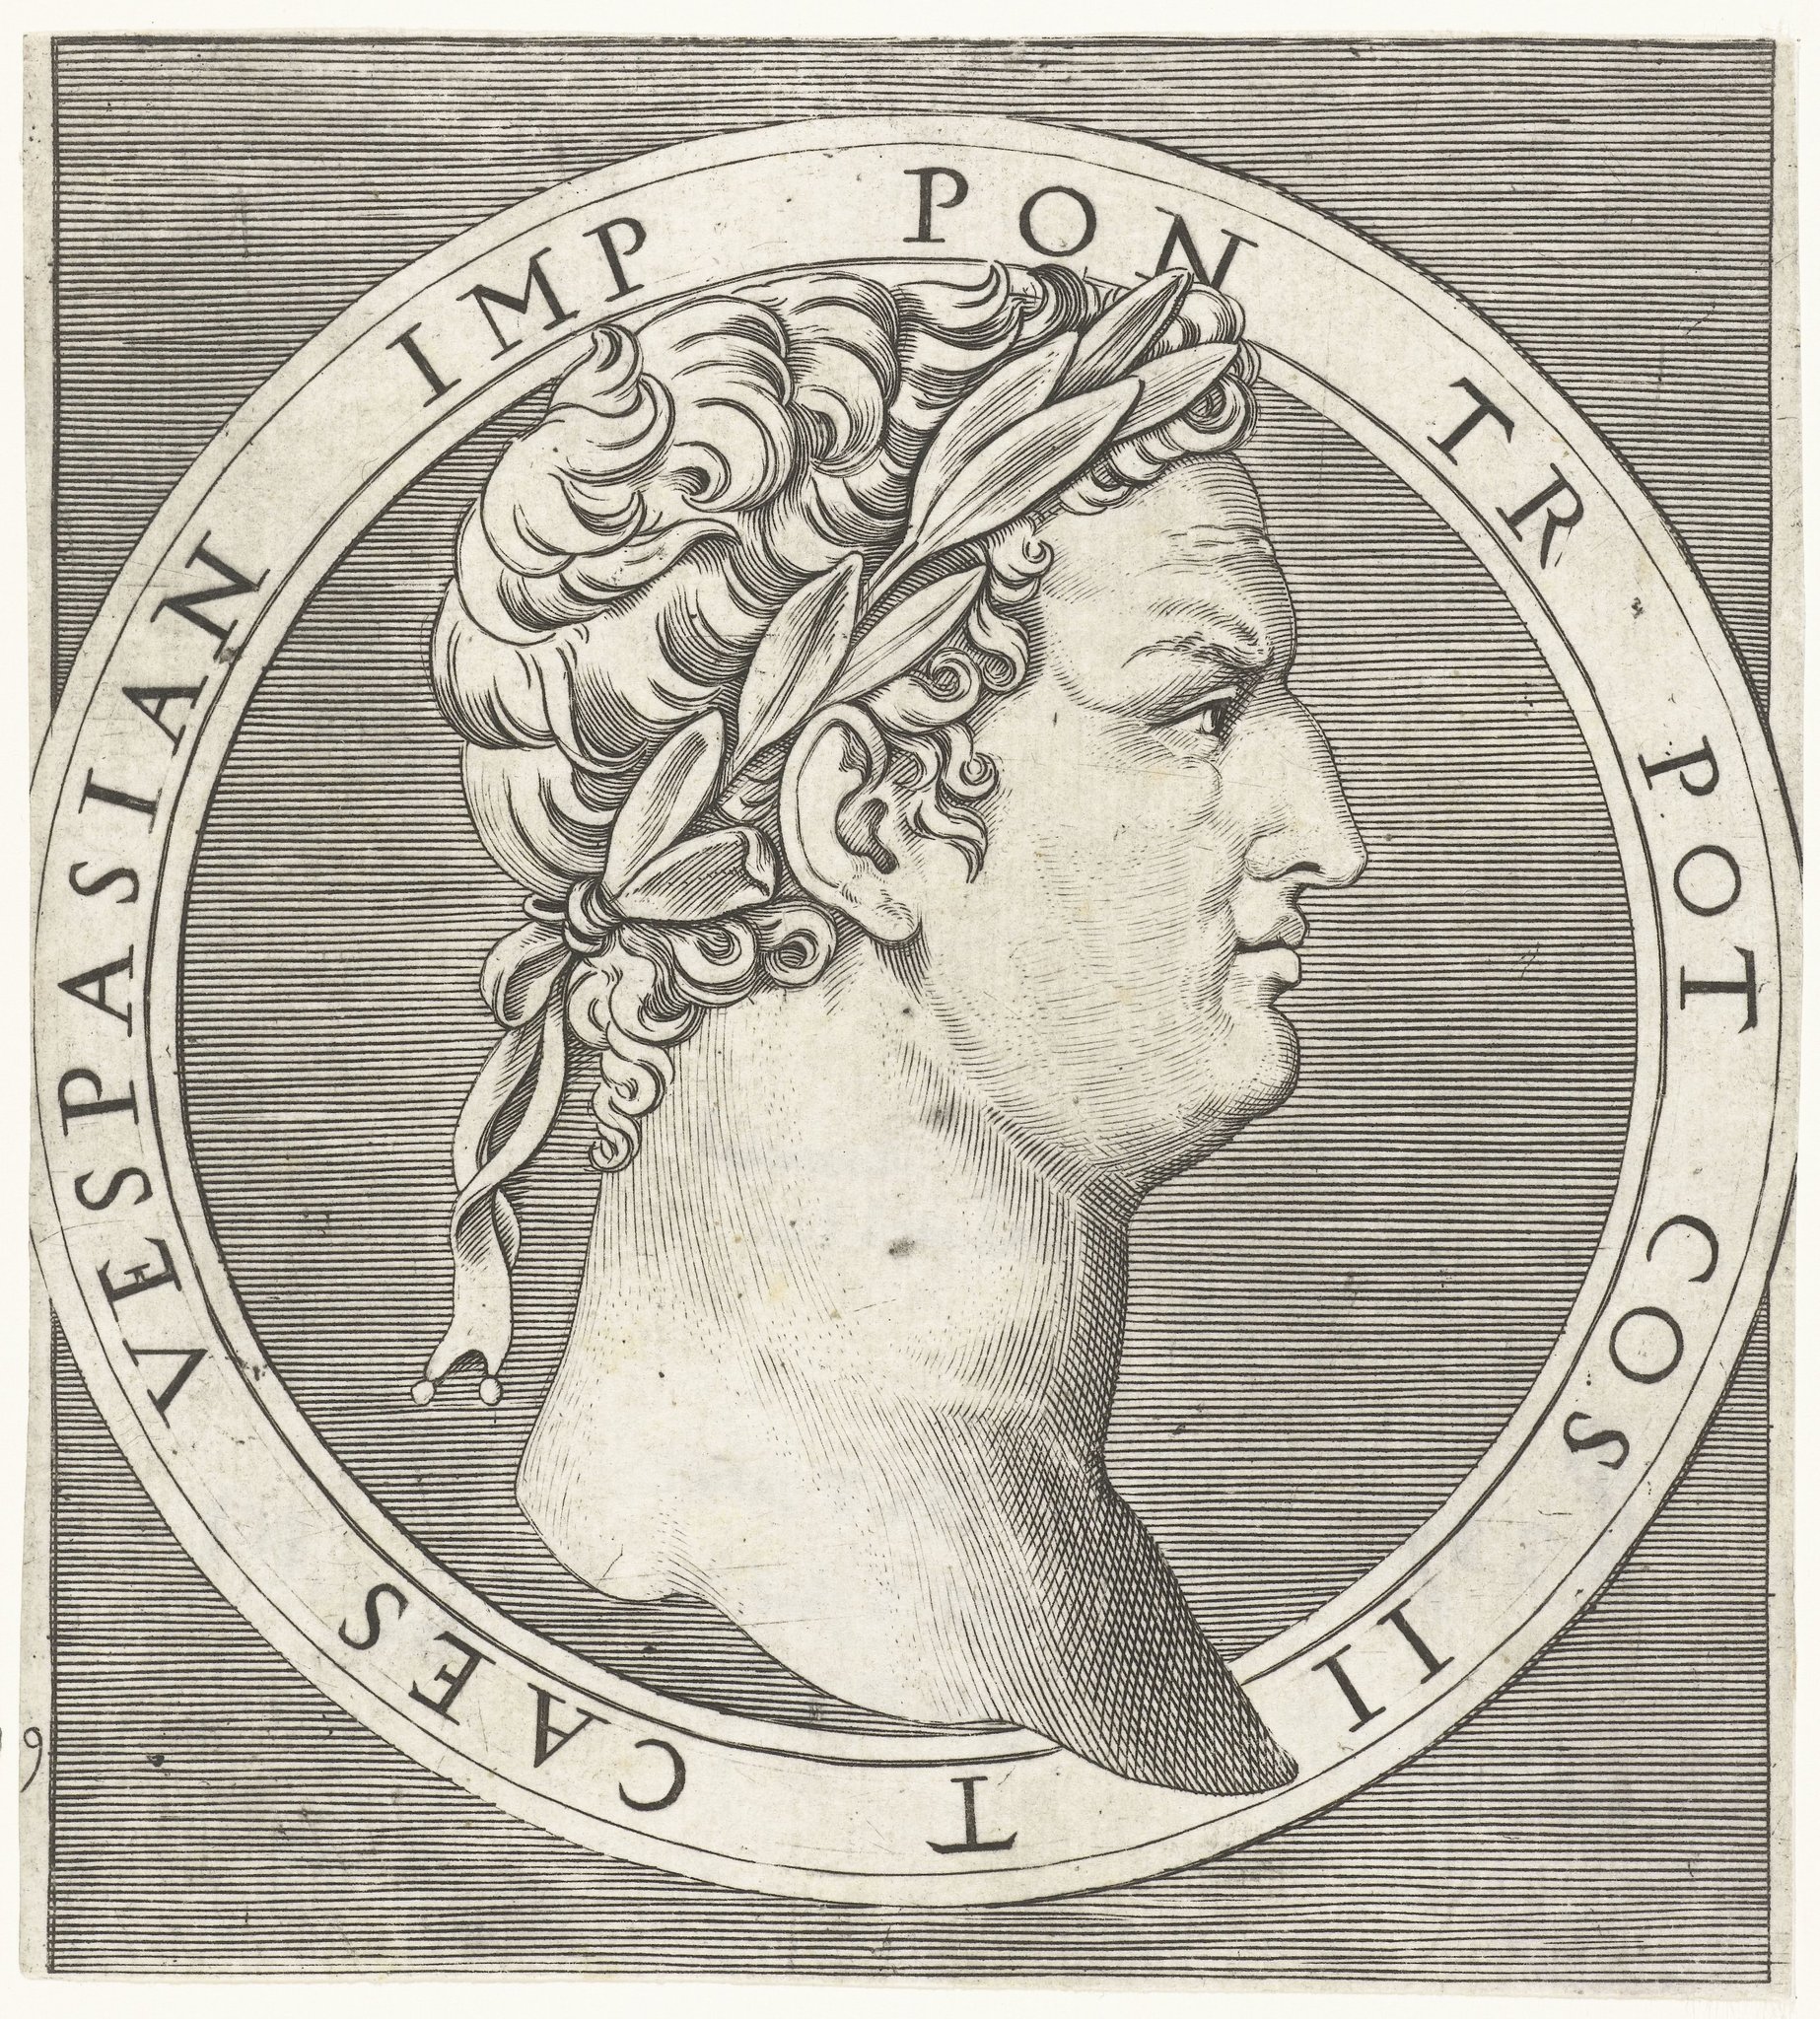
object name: print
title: Romeinse keizers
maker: marcantonio raimondi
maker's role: print maker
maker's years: 1470-1534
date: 1510-1527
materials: paper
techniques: engraving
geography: italy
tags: emperor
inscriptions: collector's mark: Lugt 12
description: Prent uit serie van twaalf prenten met Romeinse keizers.